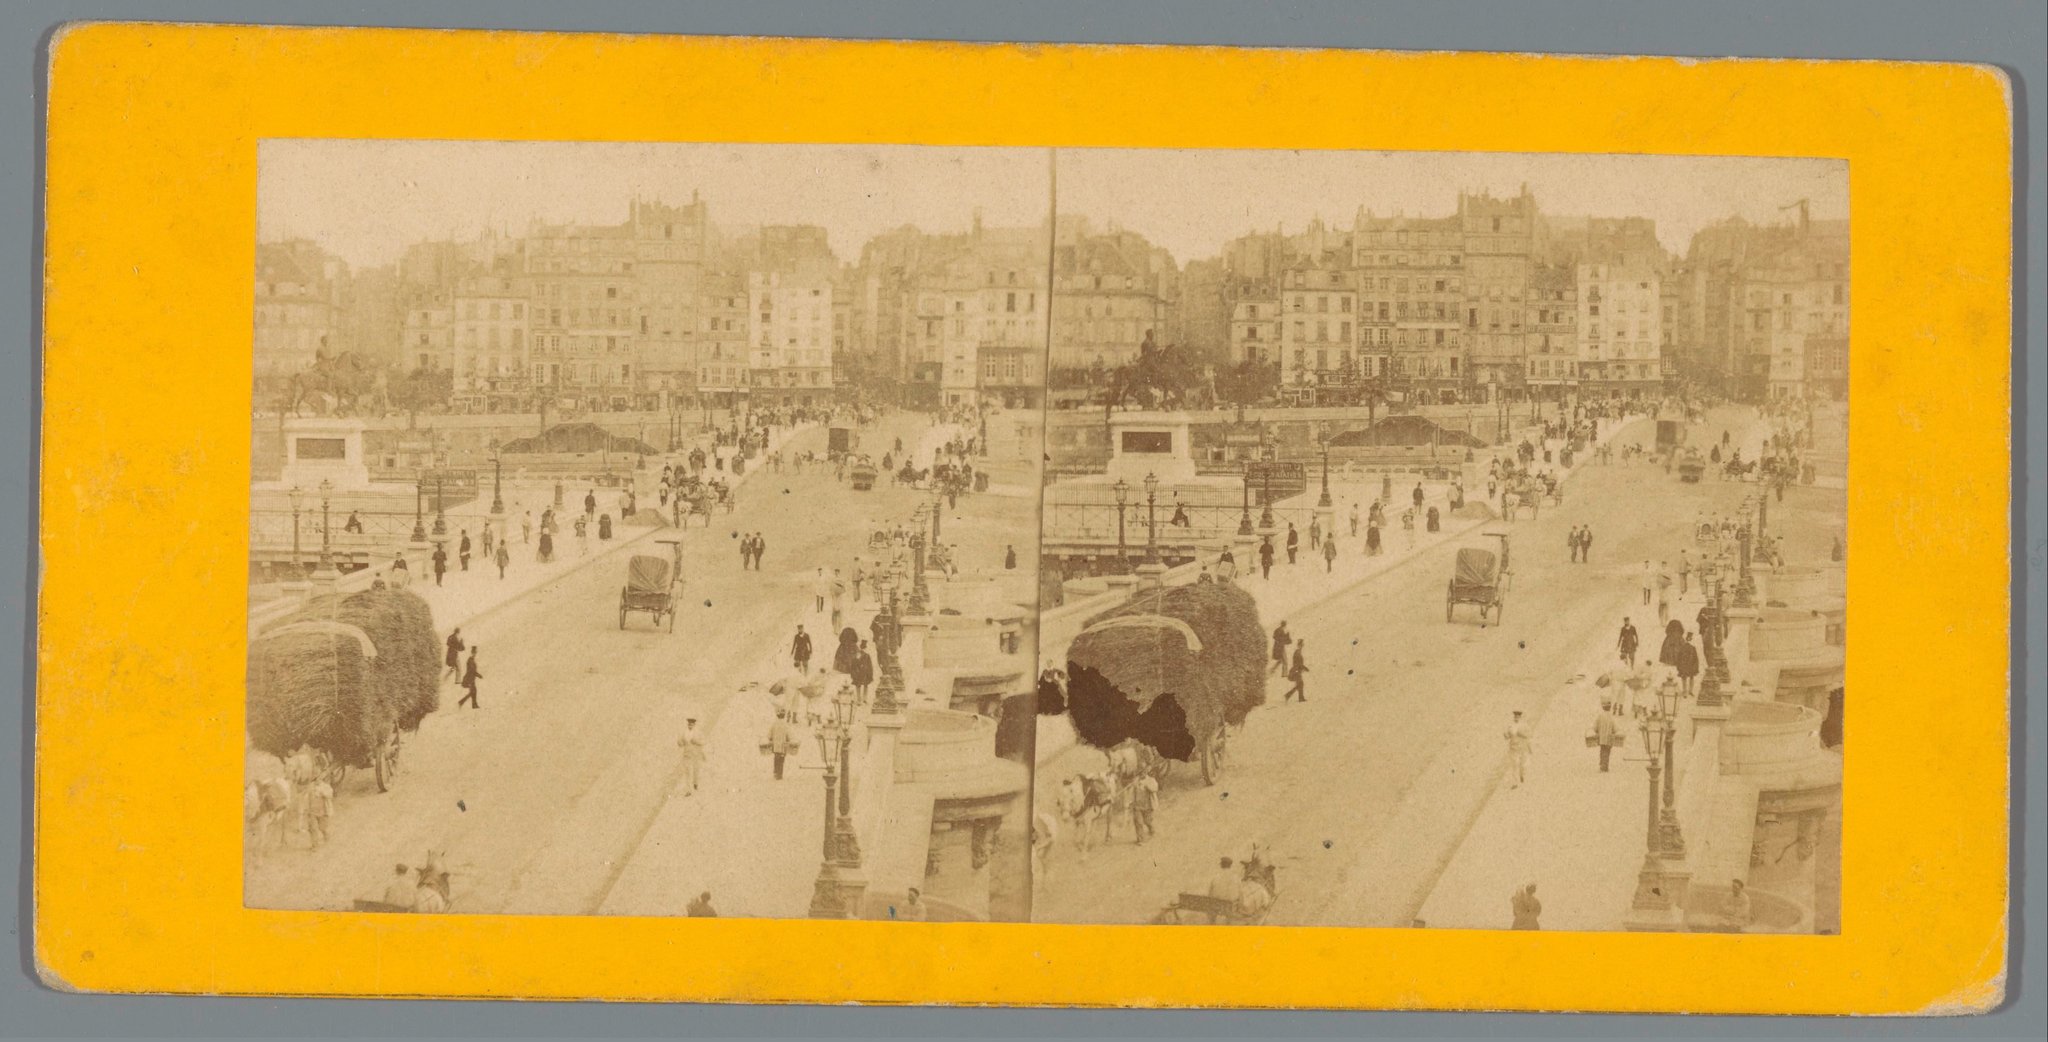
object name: stereograph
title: Gezicht op de Pont Neuf in Parijs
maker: Anonymous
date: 1850-1880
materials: cardboard, photographic support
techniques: albumen print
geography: paris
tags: two-wheeled, animal-drawn vehicle, bridge in city across river, canal, etc.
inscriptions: inscription: ‘Le Pont Neuf. Paris. 50’